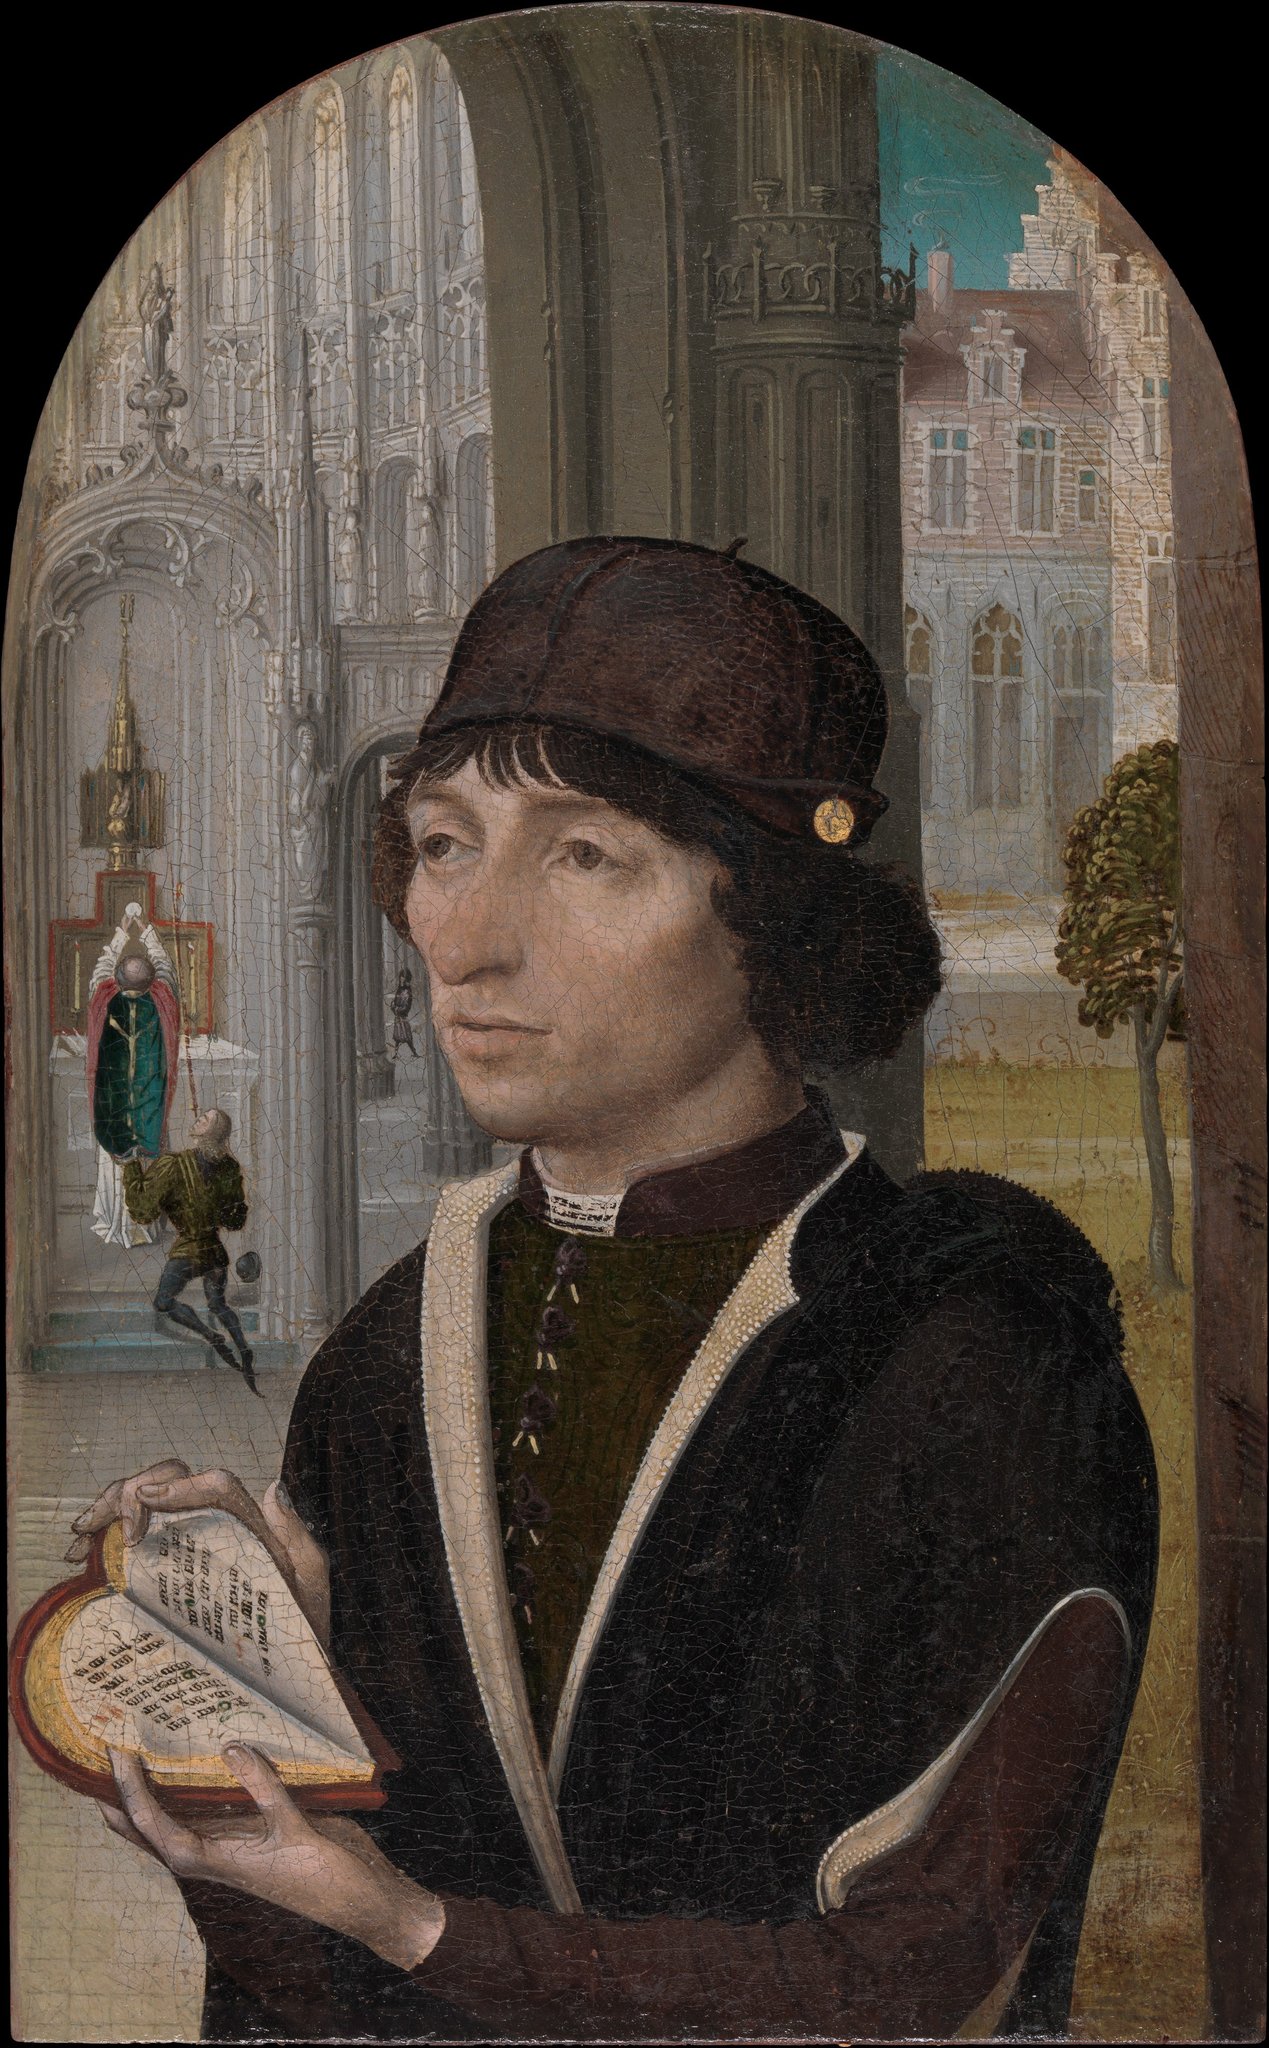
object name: painting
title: Young Man Holding a Book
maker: master of the view of saint gudula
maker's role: artist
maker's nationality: netherlandish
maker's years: 1485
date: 1480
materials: oil, wood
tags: books,churches,men,portraits